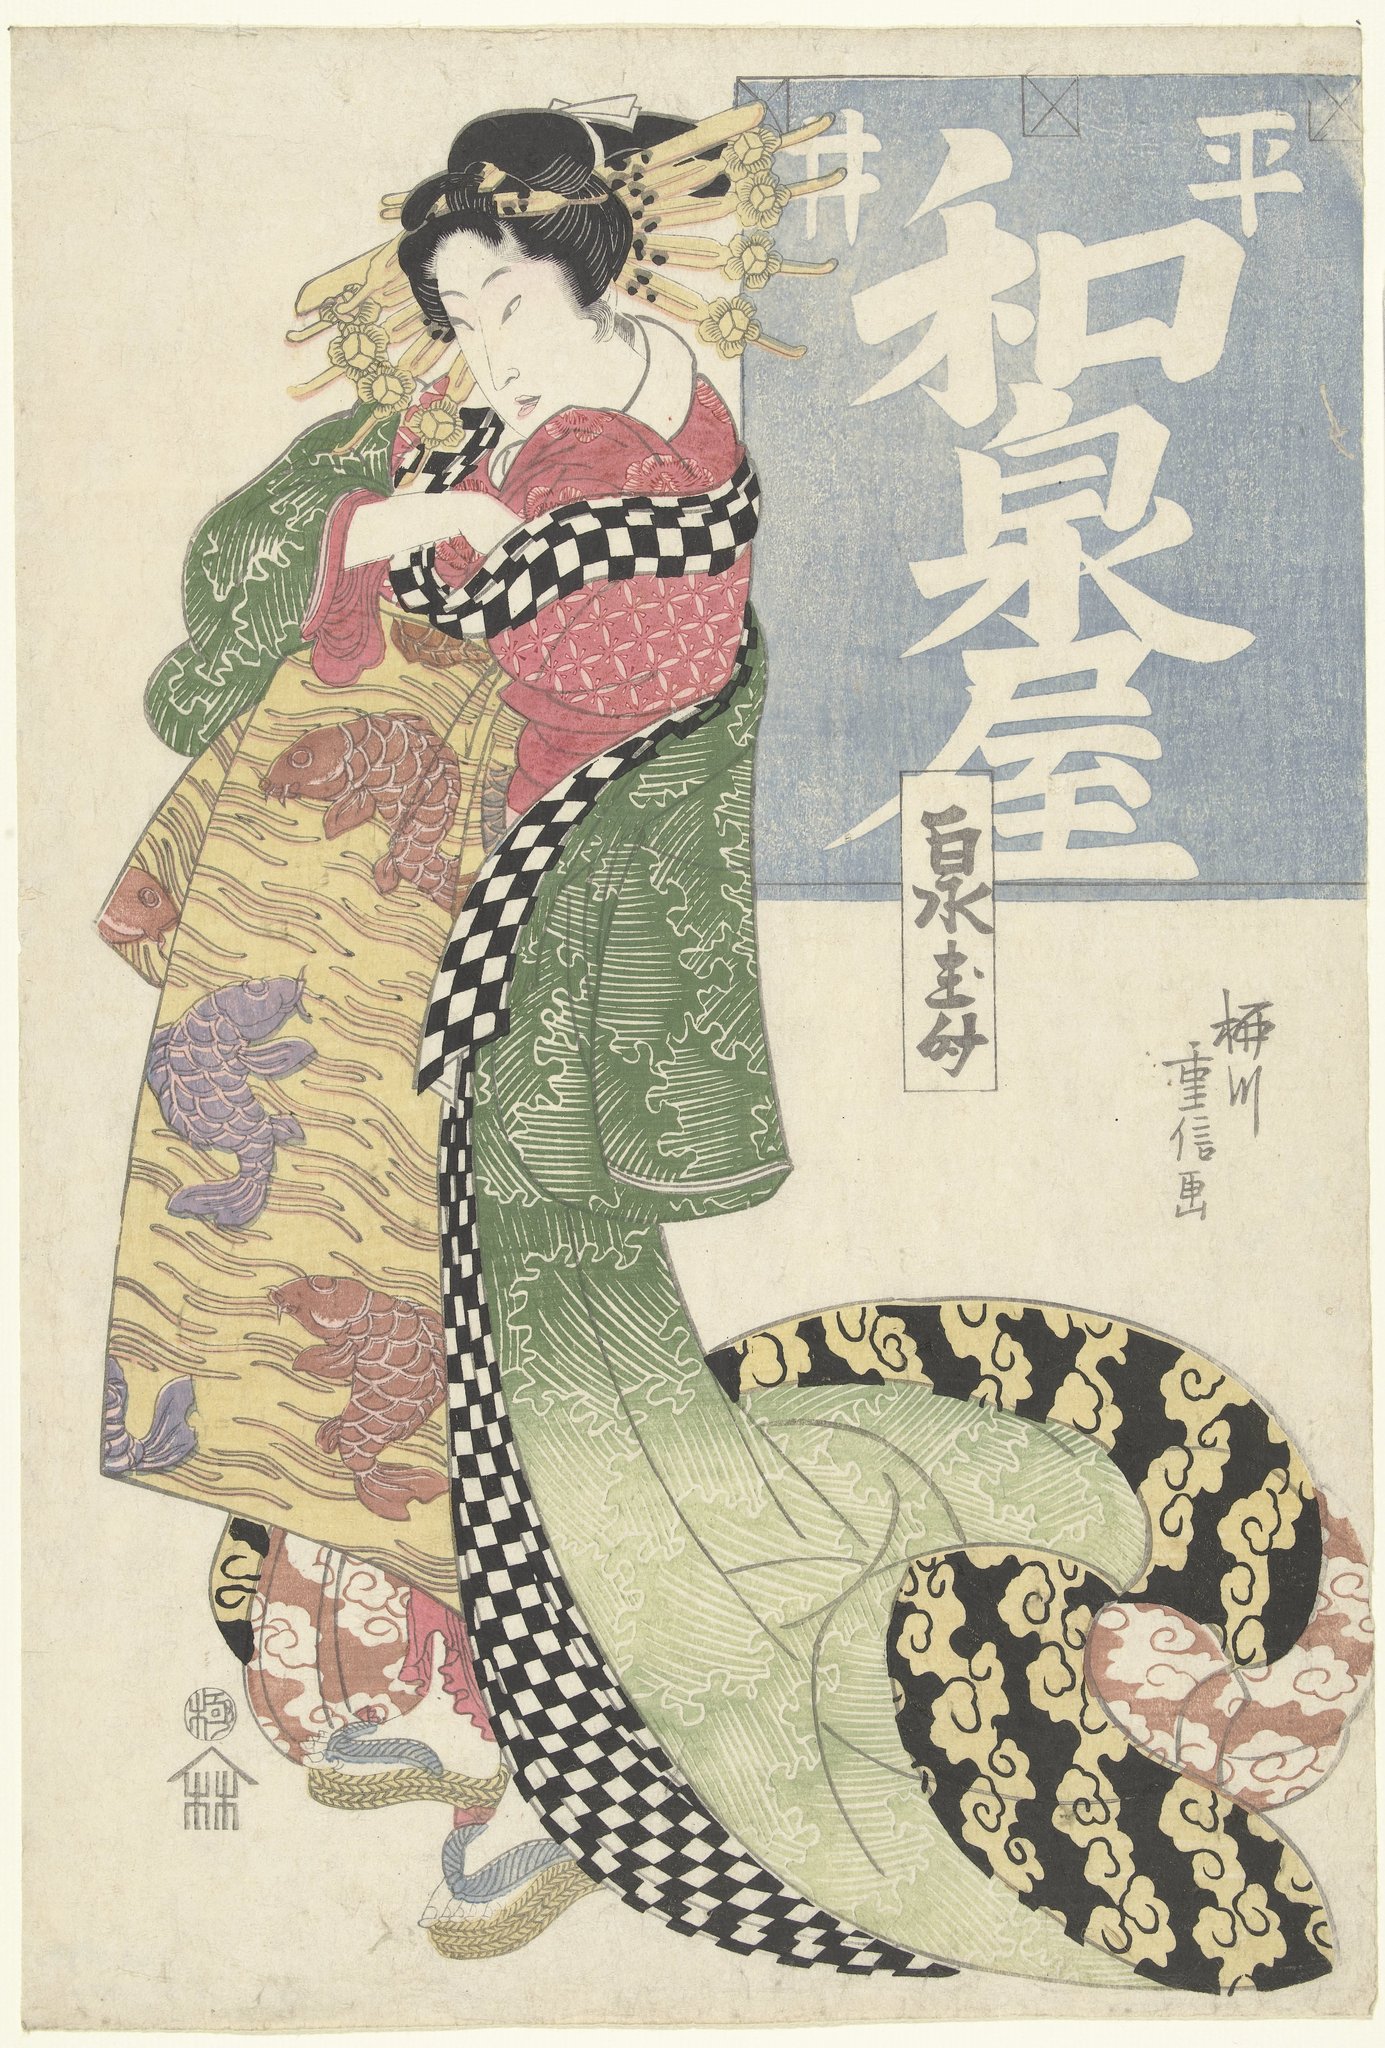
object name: print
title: Courtisane uit het Hirai Izumiya huis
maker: yanagawa shigenobu (i)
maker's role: draughtsman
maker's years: 1787-1832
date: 1815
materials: paper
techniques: woodcut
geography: japan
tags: courtesan, hetaera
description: Courtisane in kimono met zwart wit geblokte rand en gele obi met patroon van paarse en rode karpers.